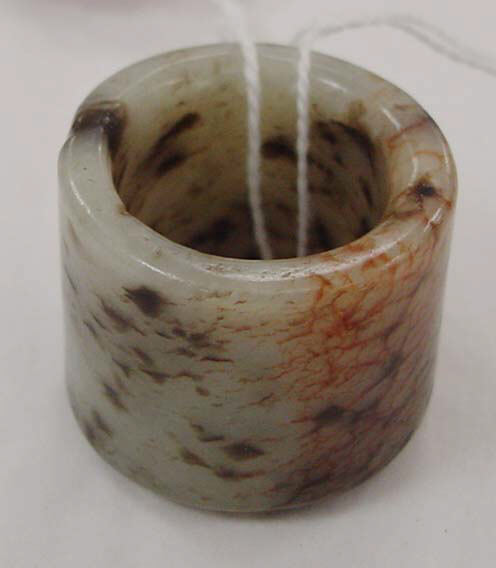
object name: ring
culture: chinese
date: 1801-1900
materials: jade